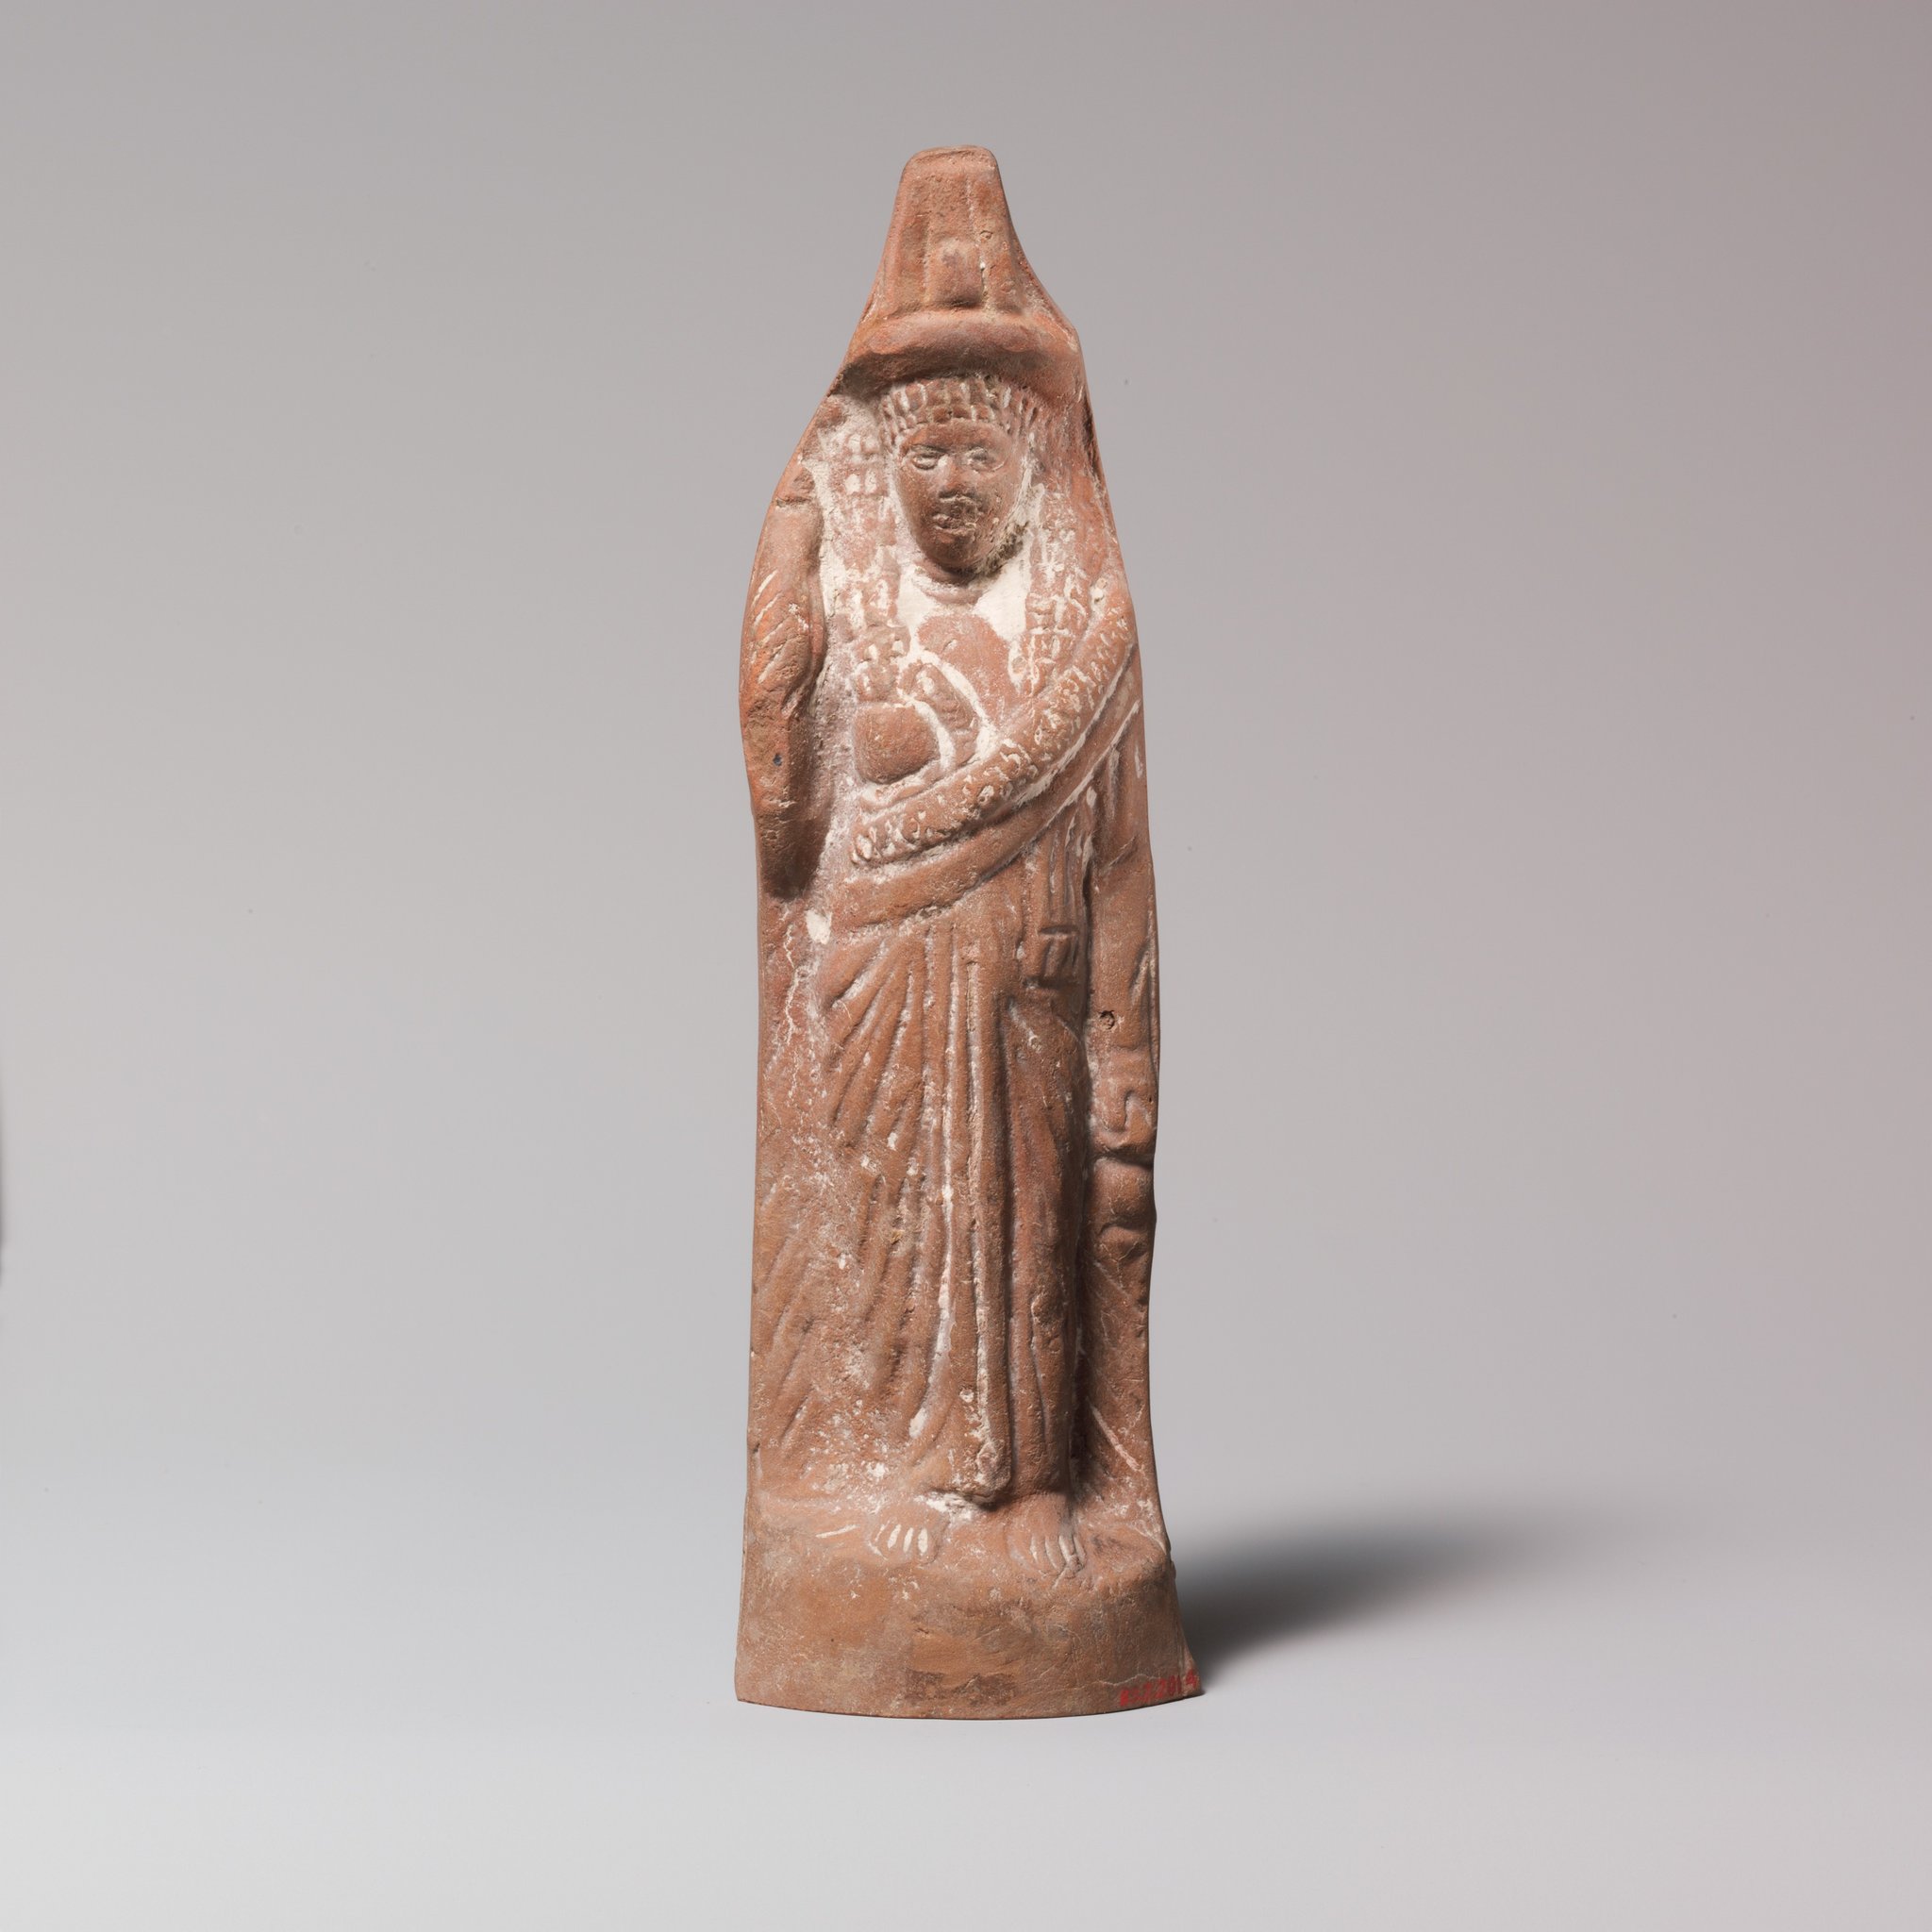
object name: statuette, isi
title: Terracotta statuette of Isis or a follower of her cult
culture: roman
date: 101-200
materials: terracotta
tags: isis